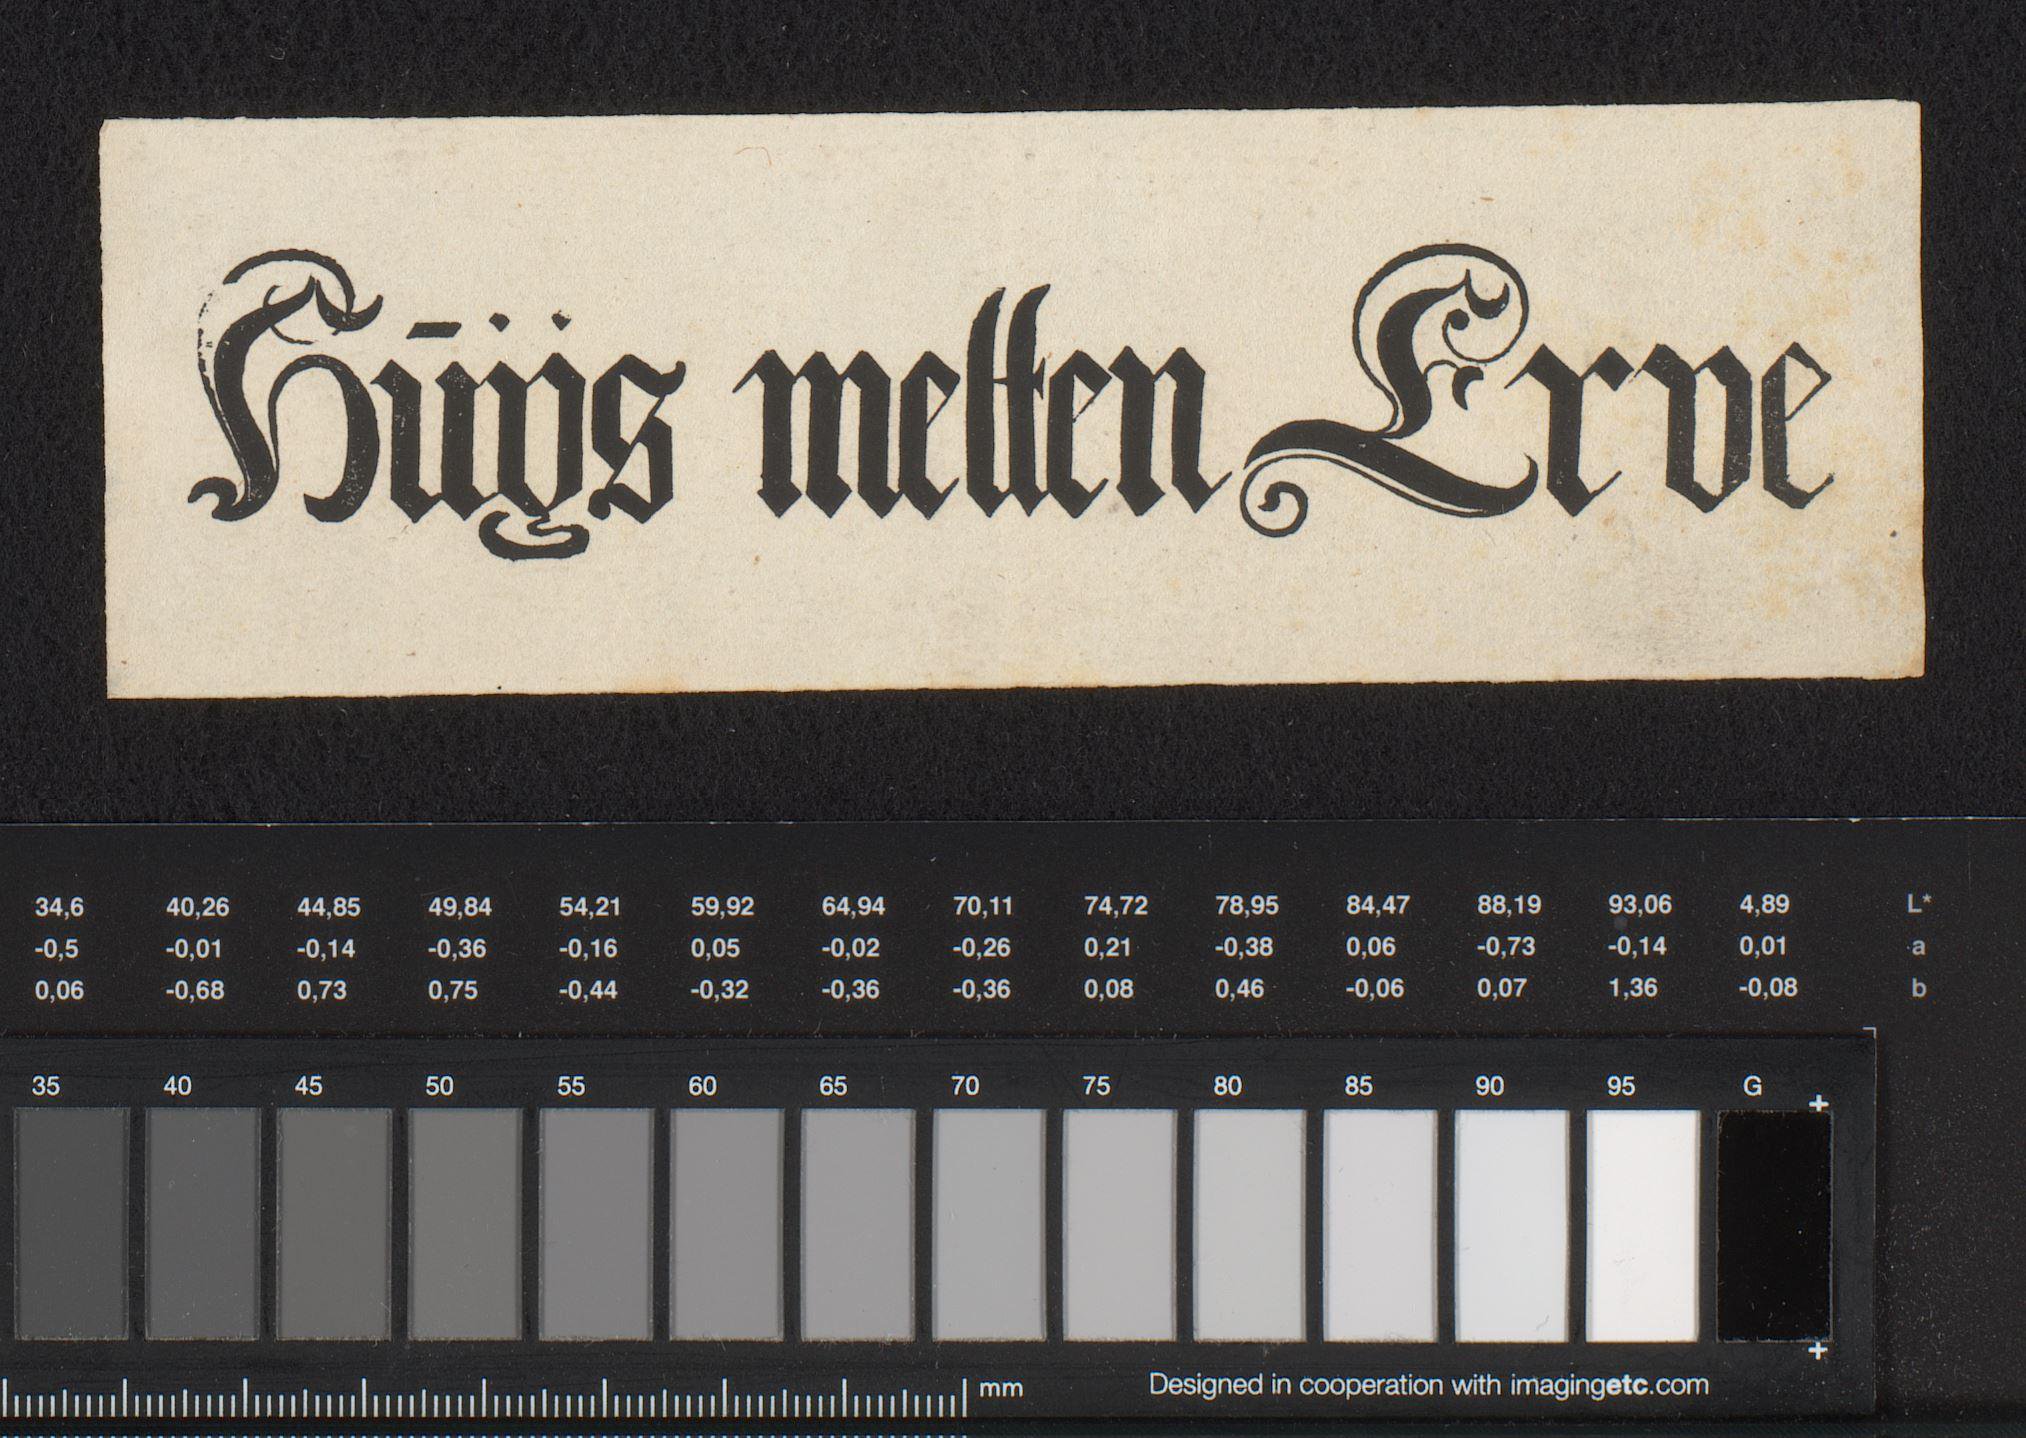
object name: print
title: Tekst 'Huys metten erve'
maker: Anonymous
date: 1600-1699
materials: paper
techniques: woodcut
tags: fancy letters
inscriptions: collector's mark: Lugt 240